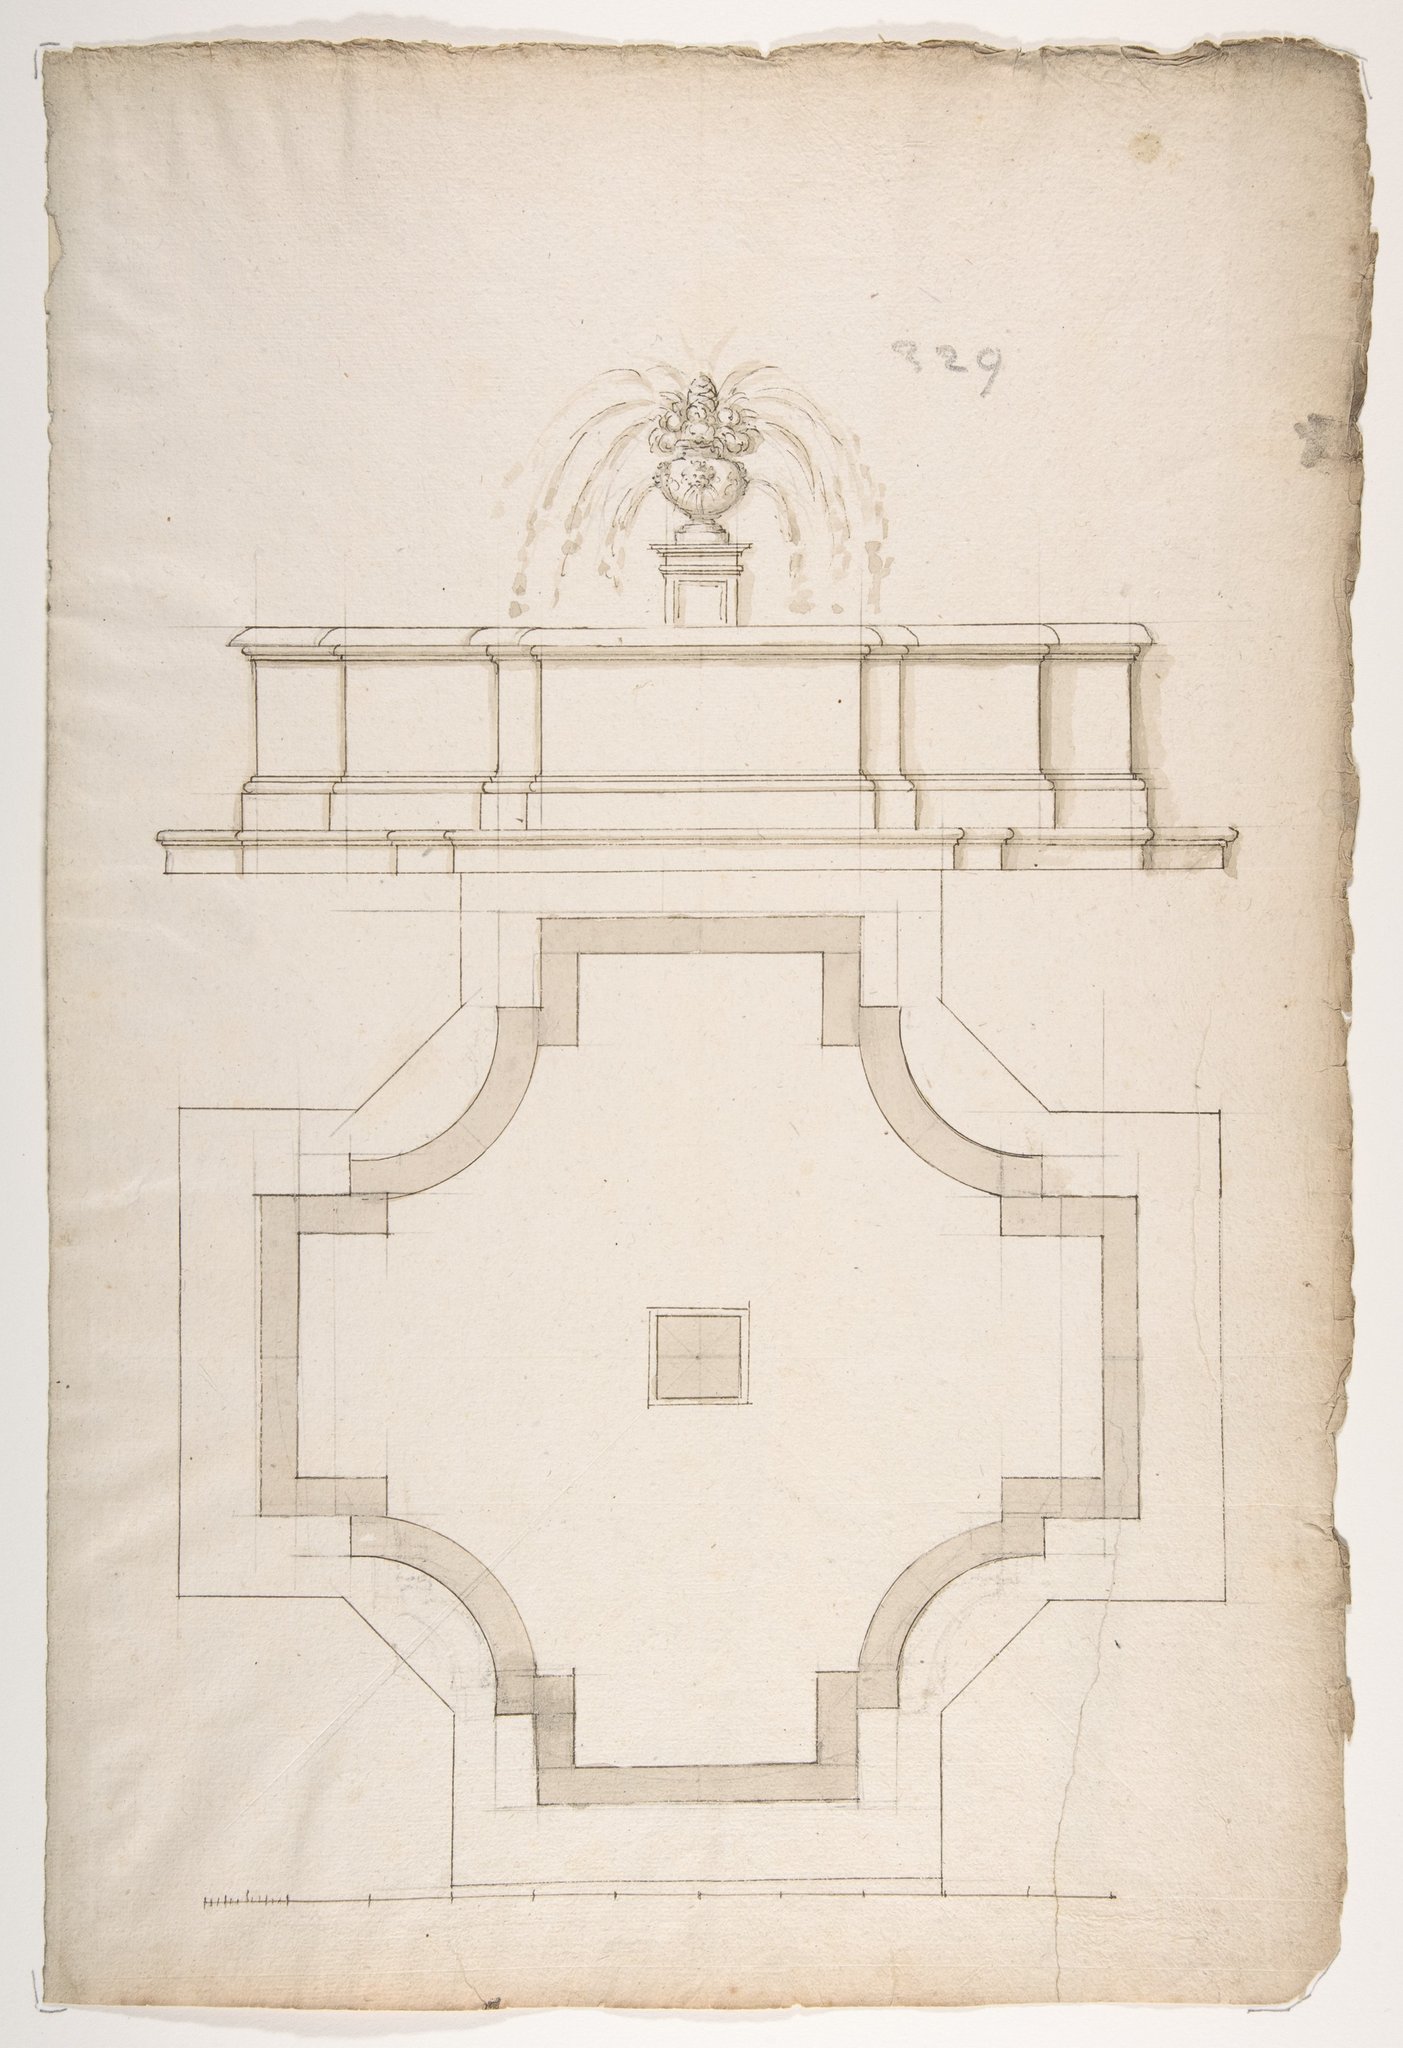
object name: drawing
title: Plan and Elevation for a Fountain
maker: anonymous, french, 16th century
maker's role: artist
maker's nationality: french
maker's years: 1500-1600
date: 1501-1600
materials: chalk, ink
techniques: brush, pen, wash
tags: architecture,fountains